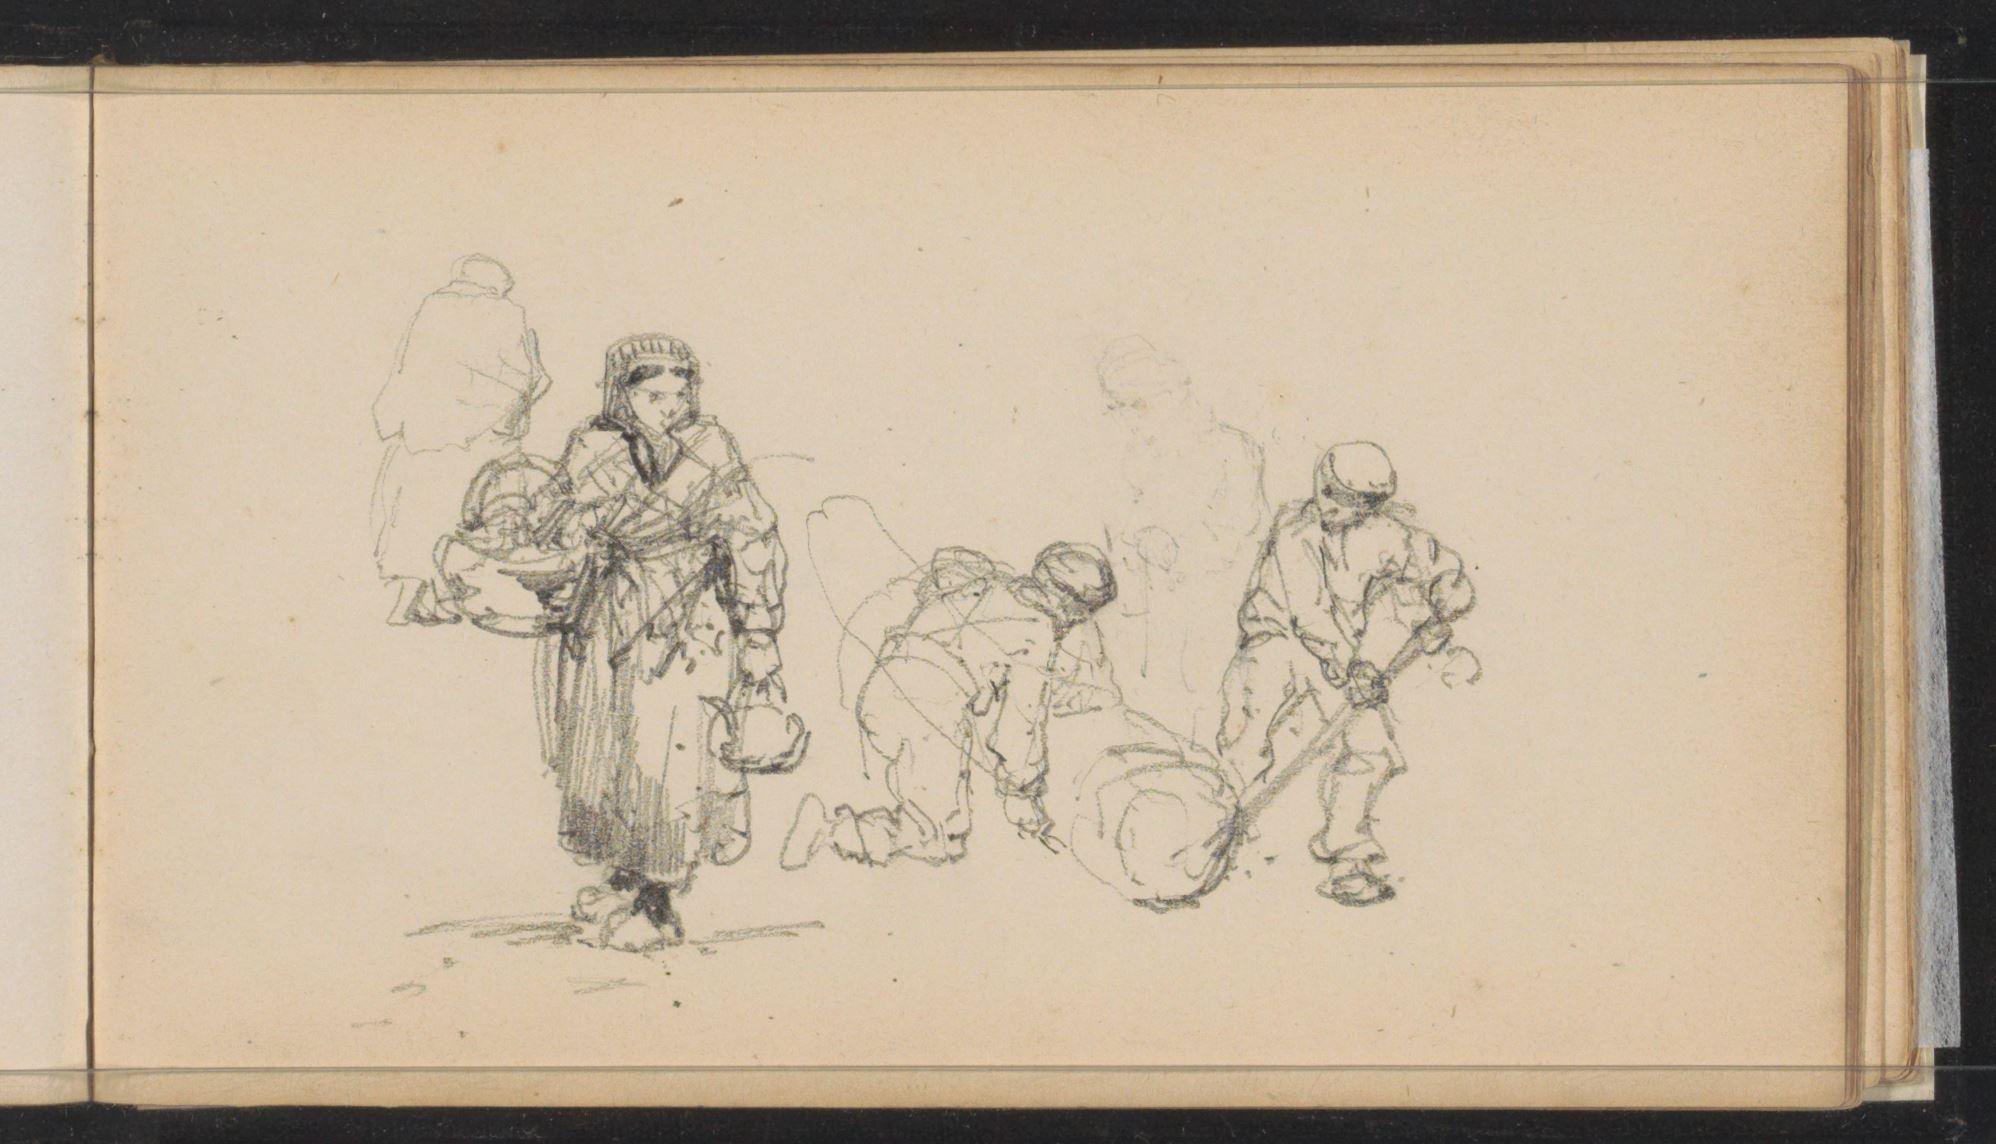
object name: sketchbook leaf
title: Figuren in verschillende houdingen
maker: cornelis springer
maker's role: draughtsman, painter, print maker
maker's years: 1817-1891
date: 1860-1866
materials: paper, pencil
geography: netherlands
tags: adult woman, adult man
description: Figuren in verschillende houdingen. Links een vrouw met een mand. Rechts mannen. Blad 31 uit een schetsboek met 44 bladen.